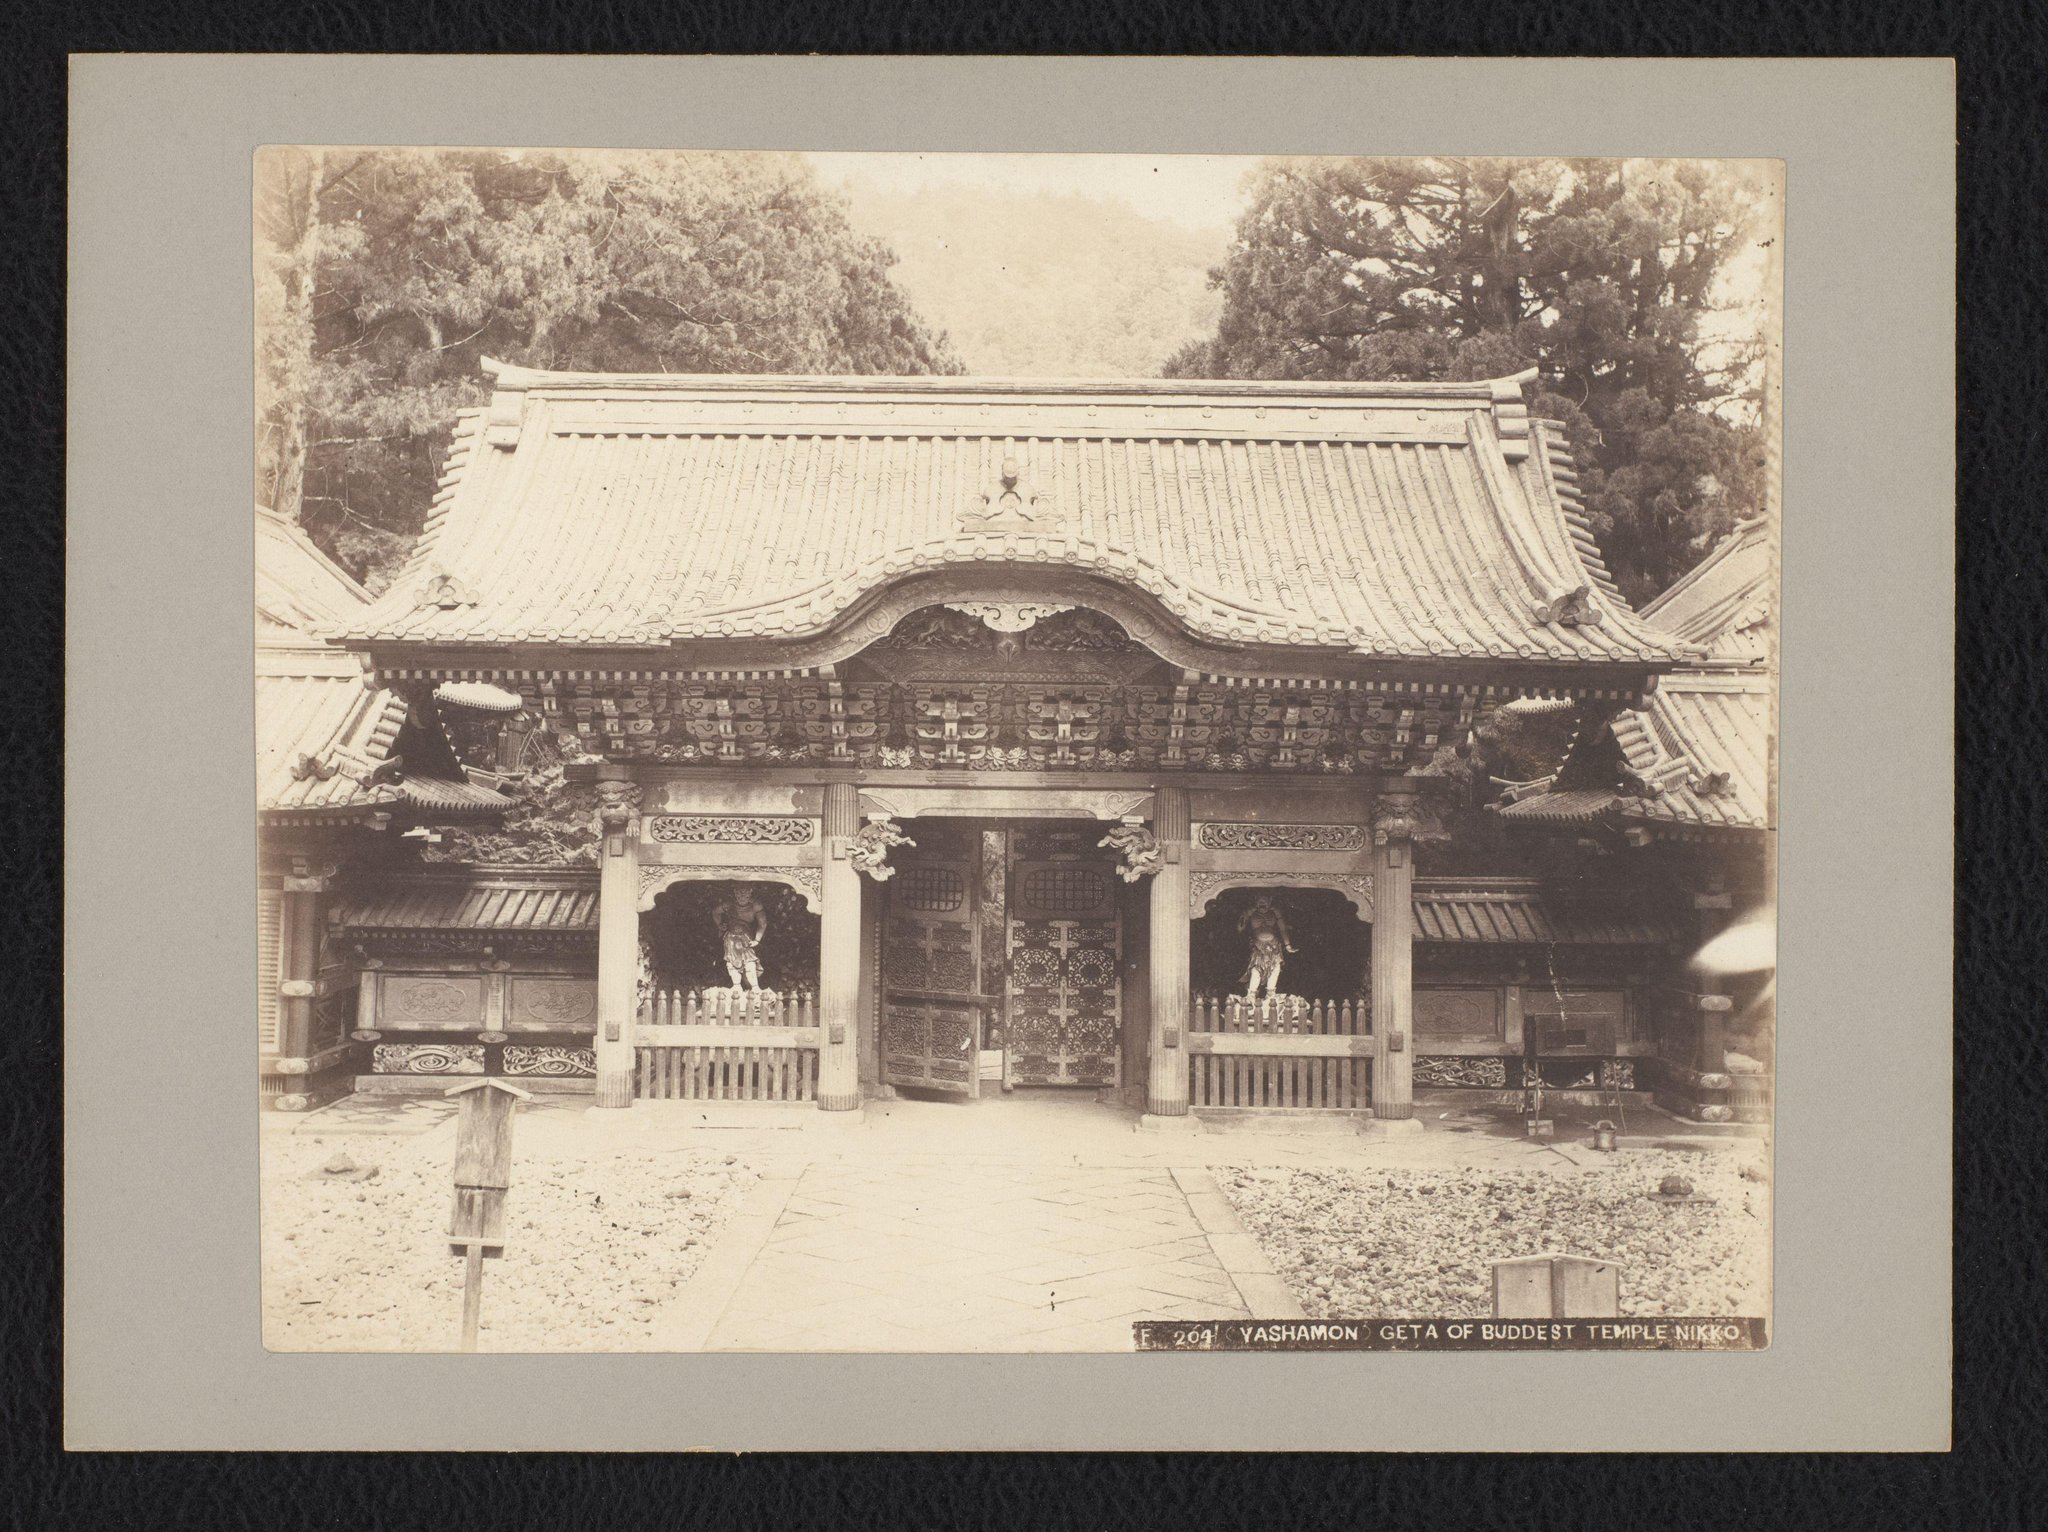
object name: photograph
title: Yashamon-poort, Nikko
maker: Anonymous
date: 1895-1915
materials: cardboard, photographic support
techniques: salted paper print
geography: nikko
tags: nikko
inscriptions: number: ‘29.’